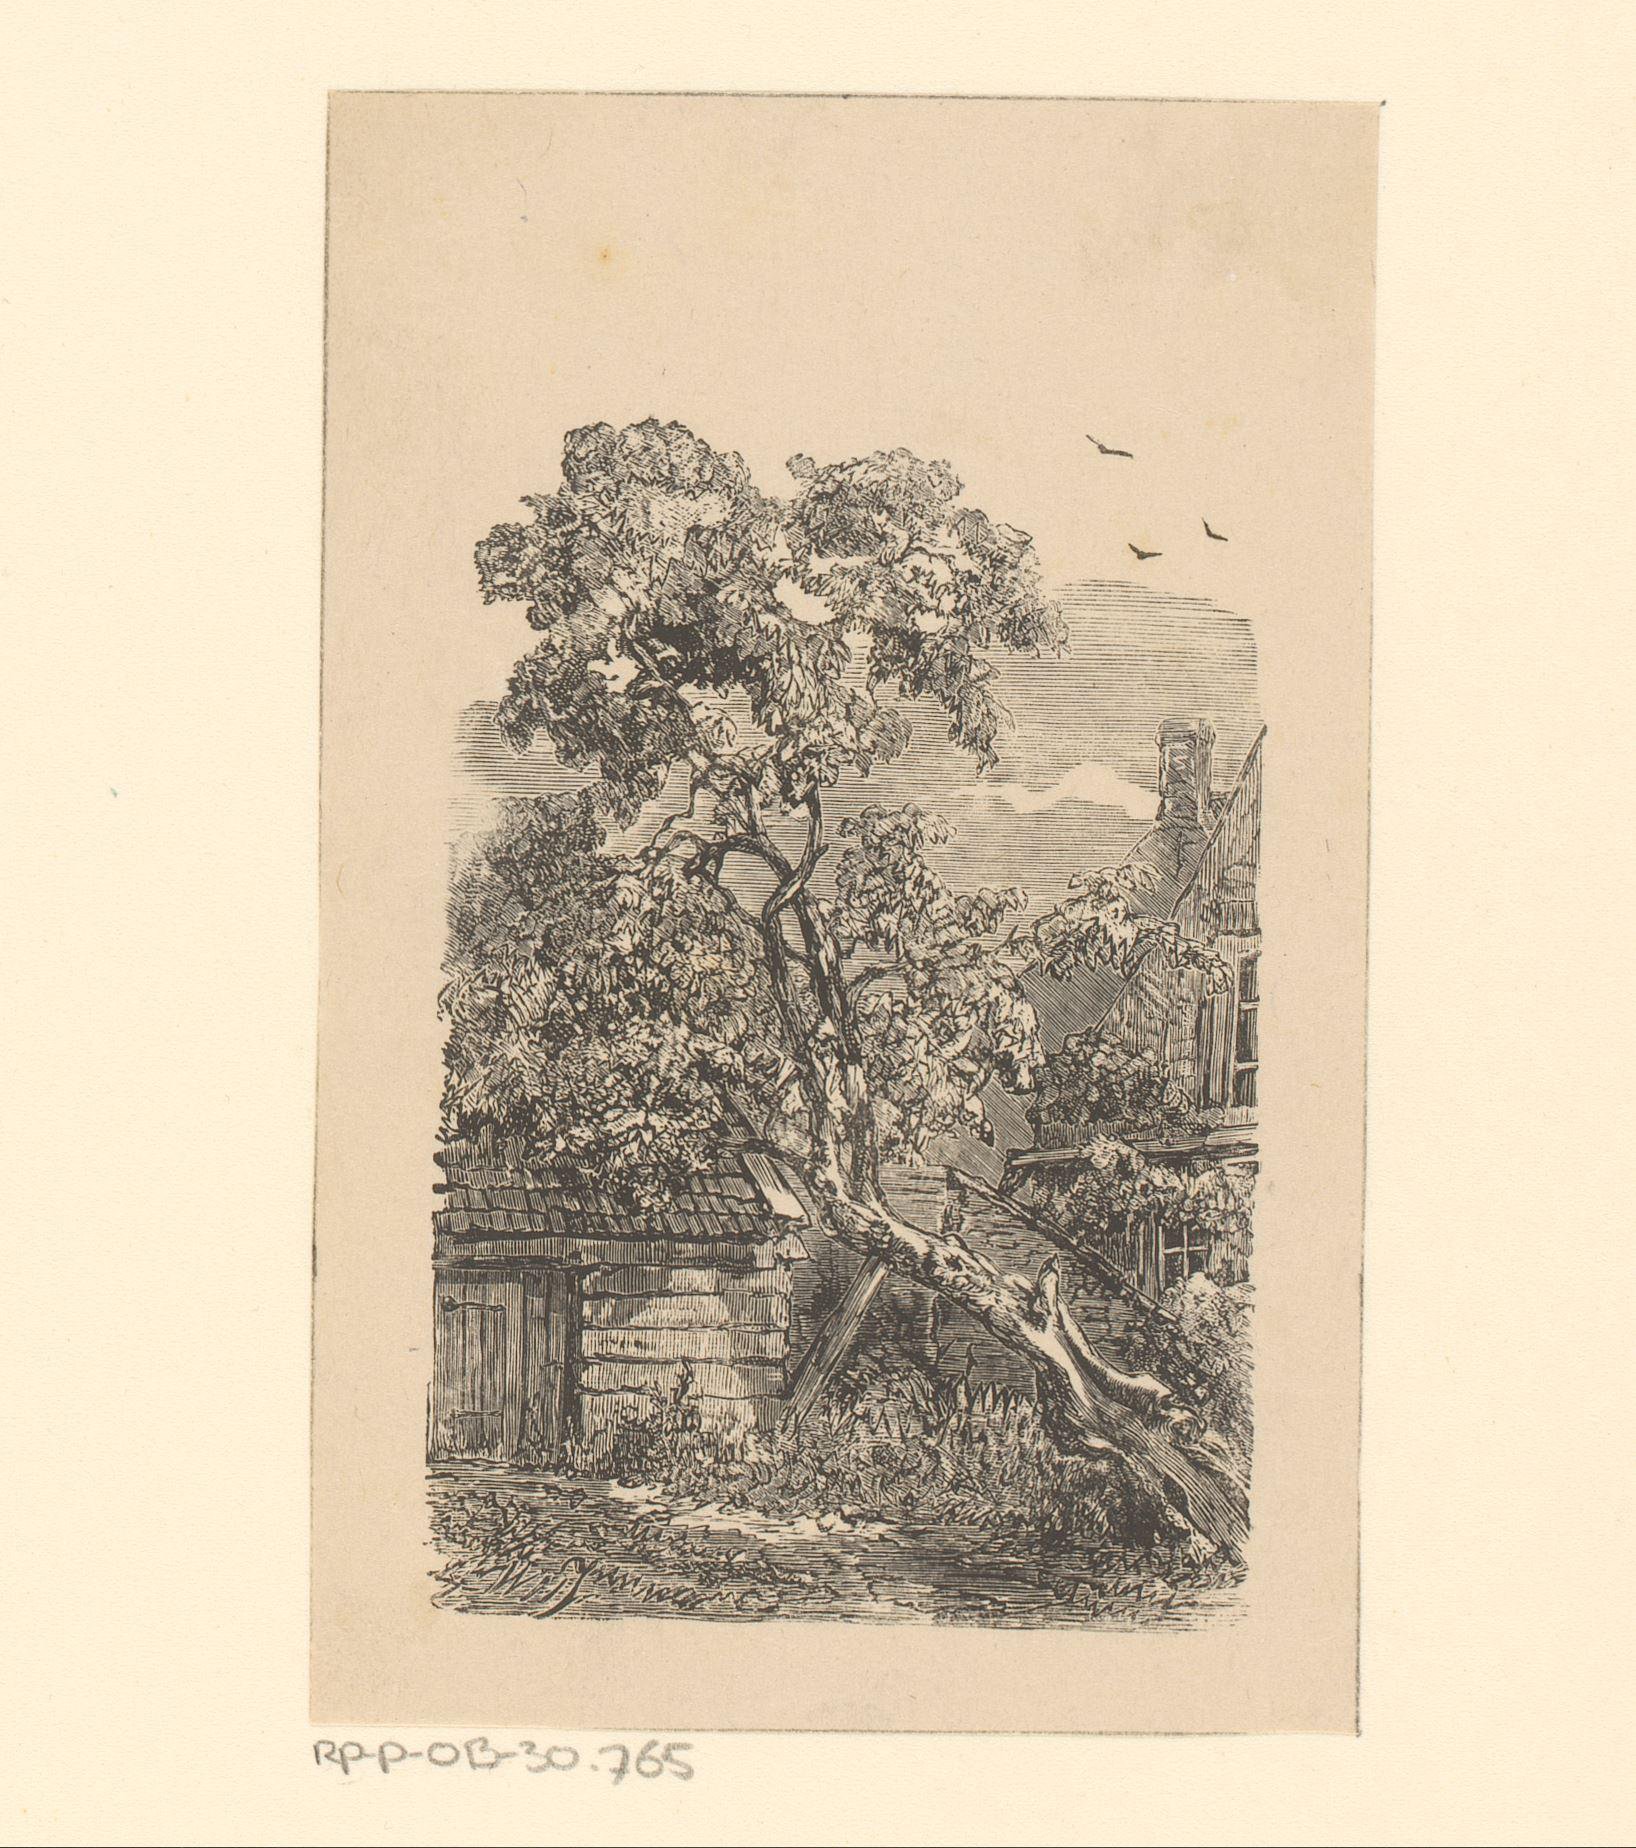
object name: print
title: Boom naast een woning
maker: isaac weissenbruch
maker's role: print maker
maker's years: 1826-1912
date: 1836-1912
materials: paper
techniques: engraving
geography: netherlands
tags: trees, civic architecture; edifices; dwellings